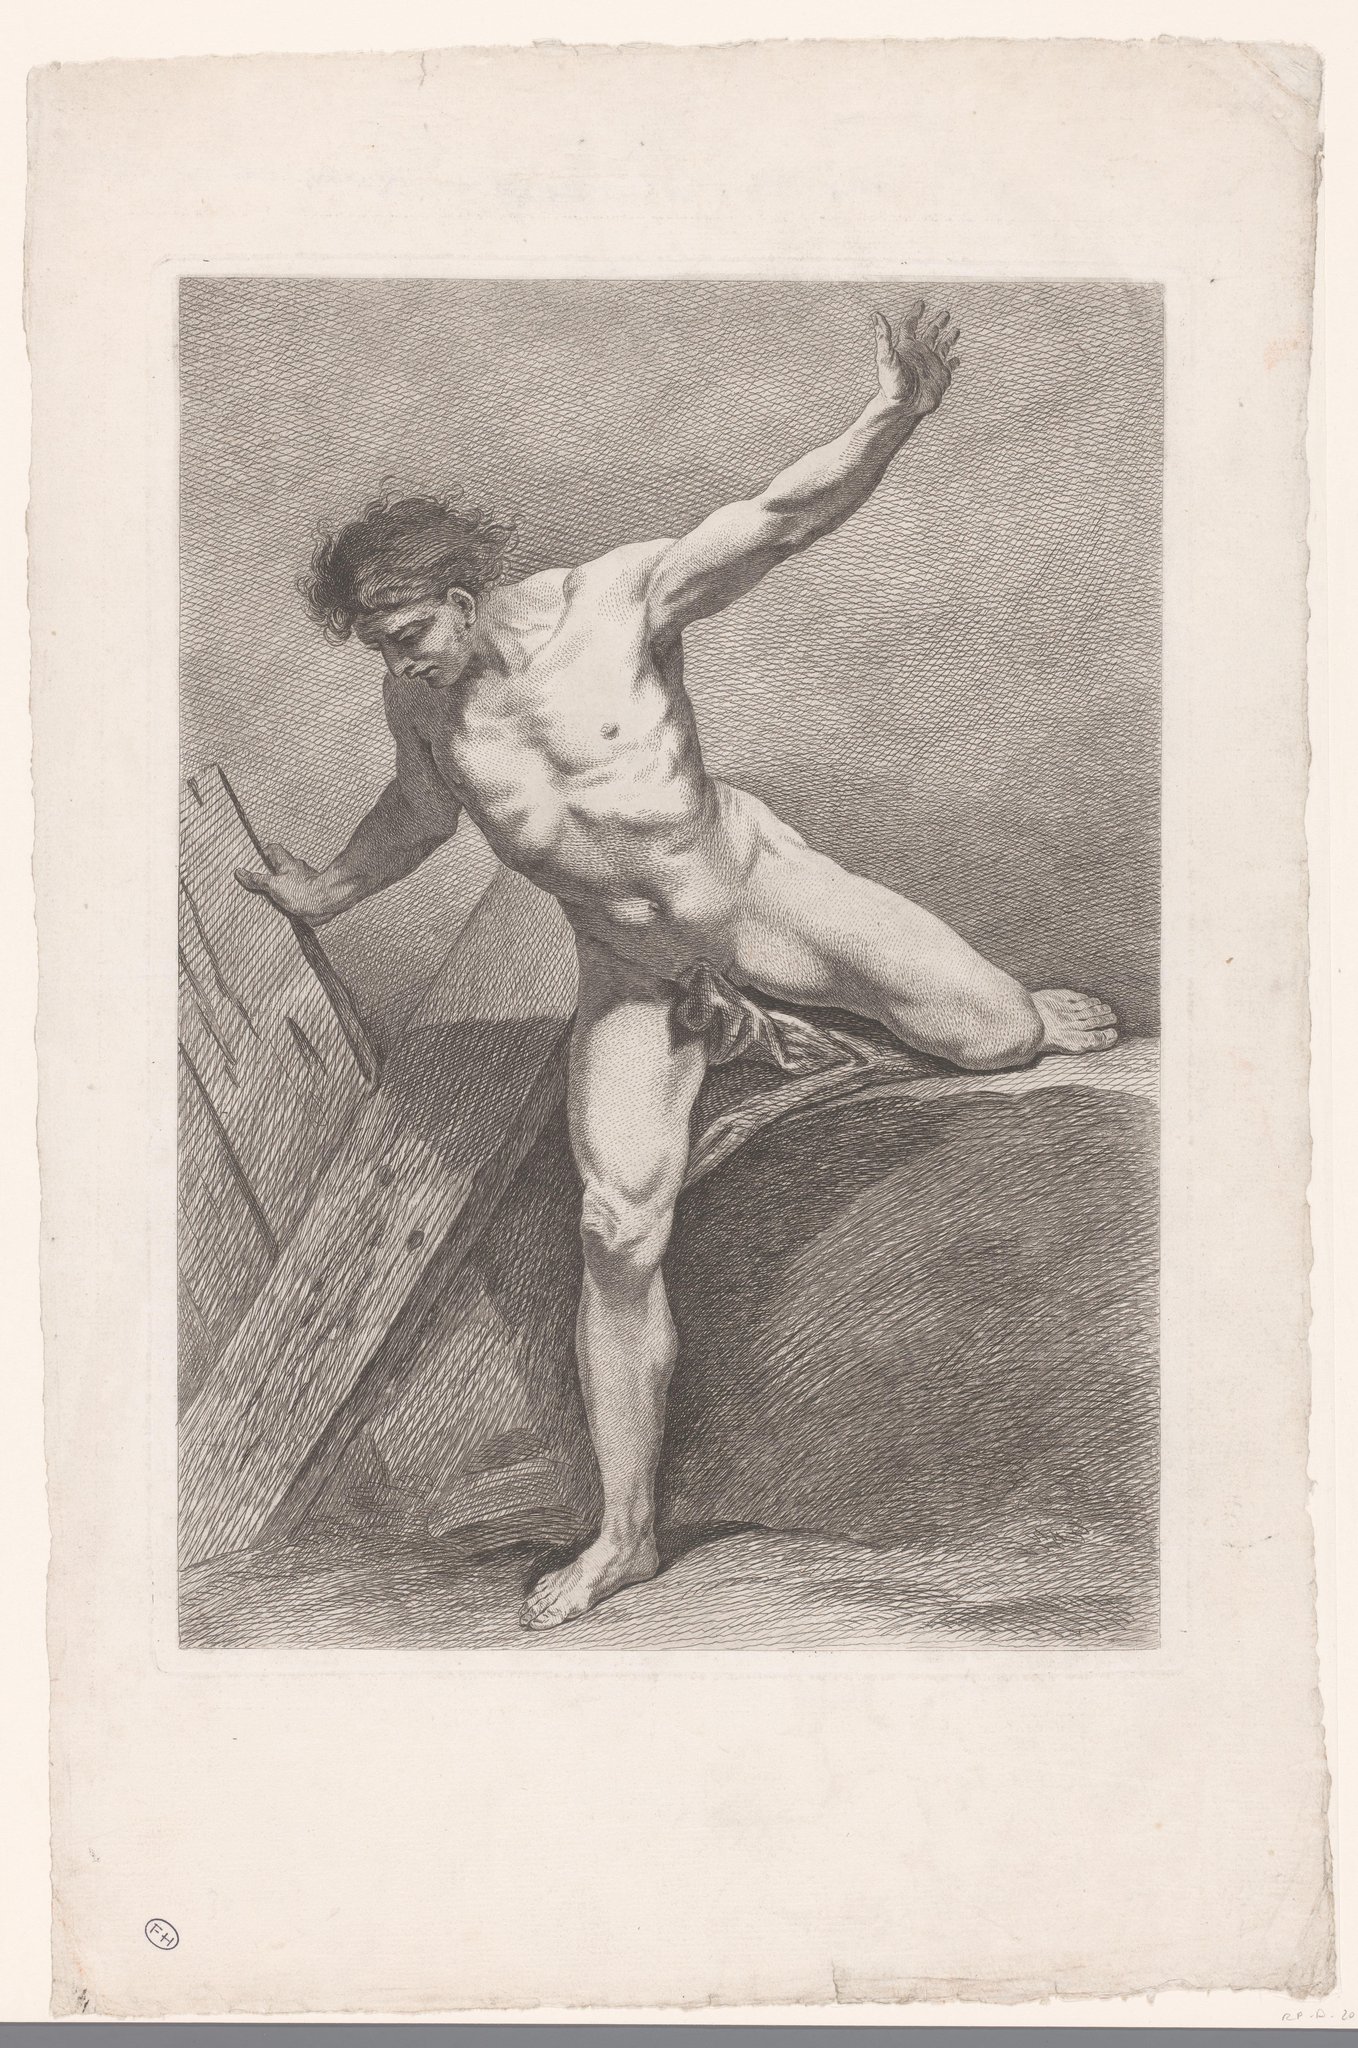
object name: print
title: Six figures academiques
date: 1743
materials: paper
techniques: etching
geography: paris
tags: human figure of ideal proportions, e.g. academic nude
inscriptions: collector's mark: Lugt 3373, collector's mark: Lugt 2760, collector's mark: Lugt 2228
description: Vier voorstudies (tekeningen in rood krijt) van deze etsen (RP-P-2014-14-1 t/m 6) worden bewaard in Stockholm (Nationaal Museum).